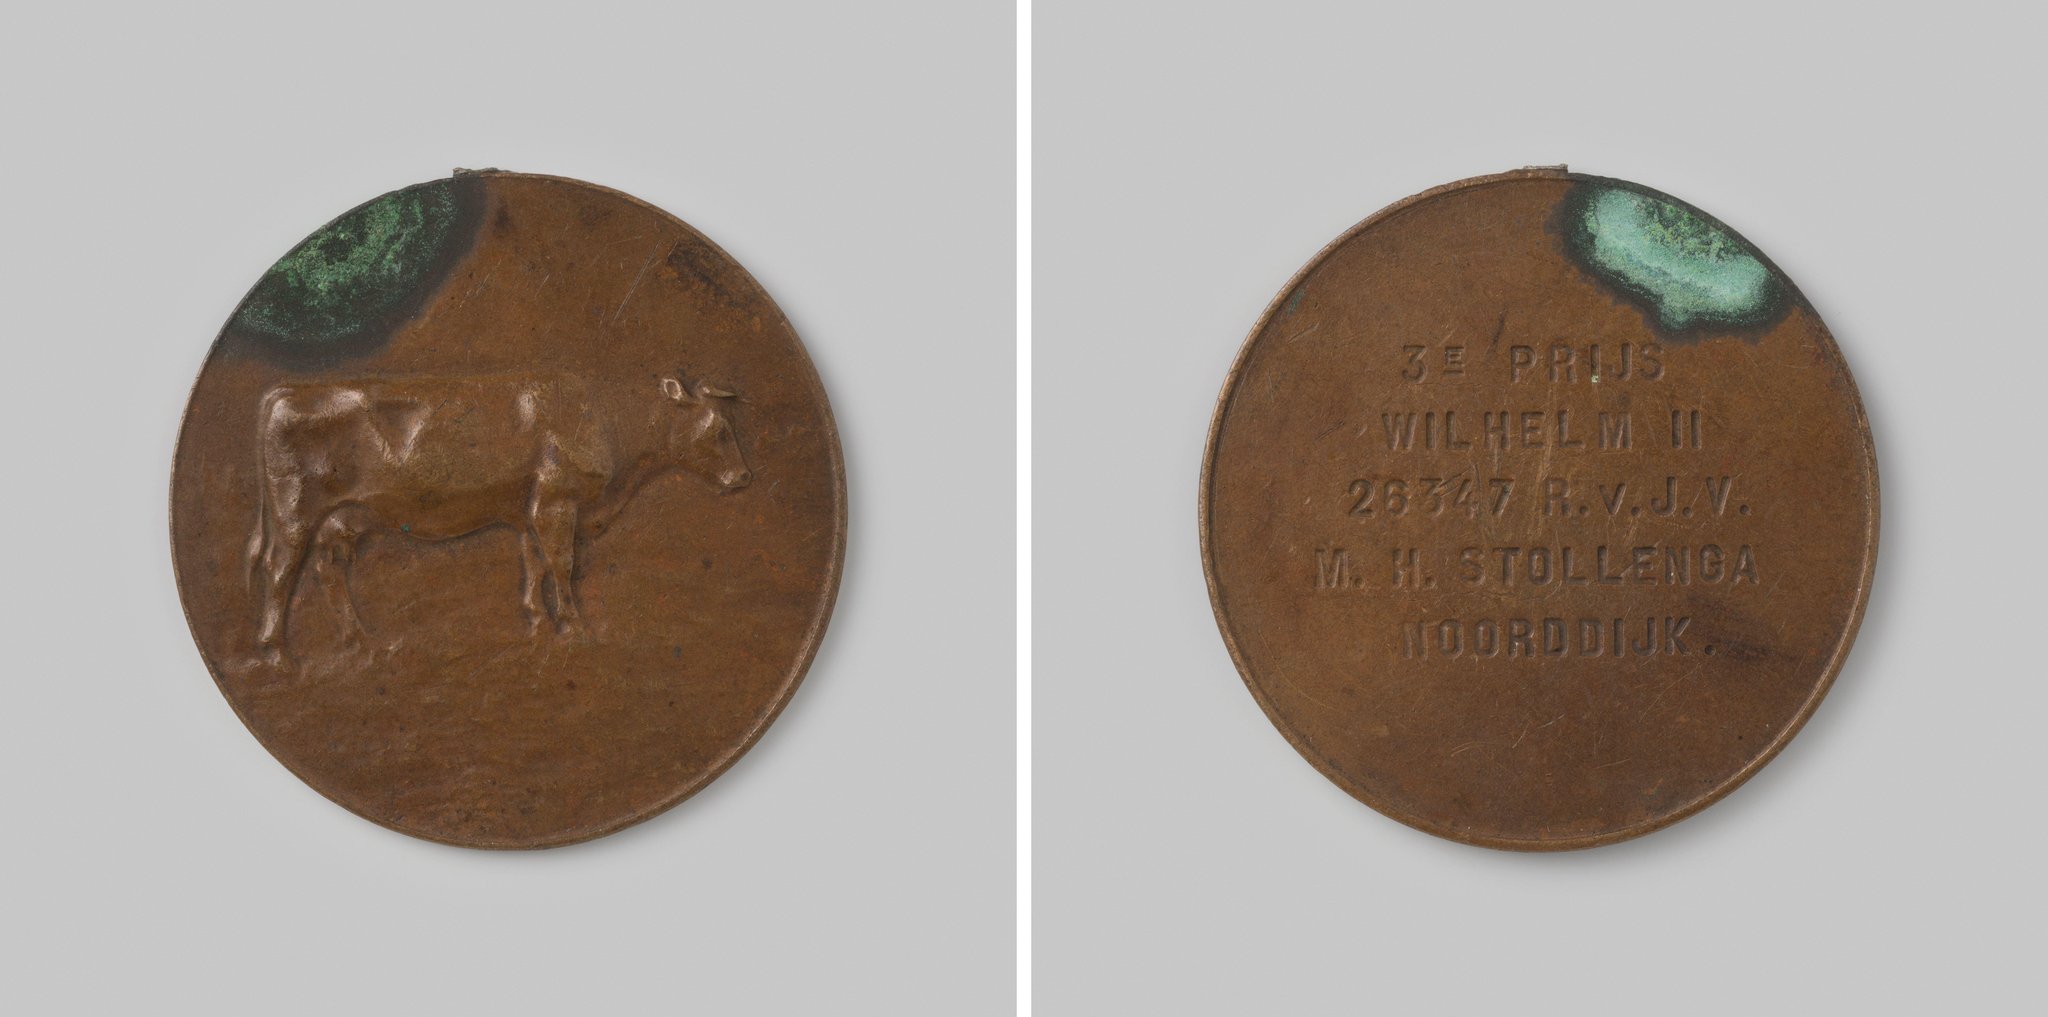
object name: history medal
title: Prijspenning voor veetelt, uitgereikt voor Wilhelm II te Noordwijk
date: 1920-1960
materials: bronze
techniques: striking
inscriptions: inscription: ‘3E PRIJS / WILHELM II / 26347 R.v,J,V, / M.H. STOLLENGA / NOORDWIJK.’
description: Bronzen penning, op de voorzijde een koe in grasland, op de keerzijdeeen vijfregelige inscriptie, verwijderd draagoog